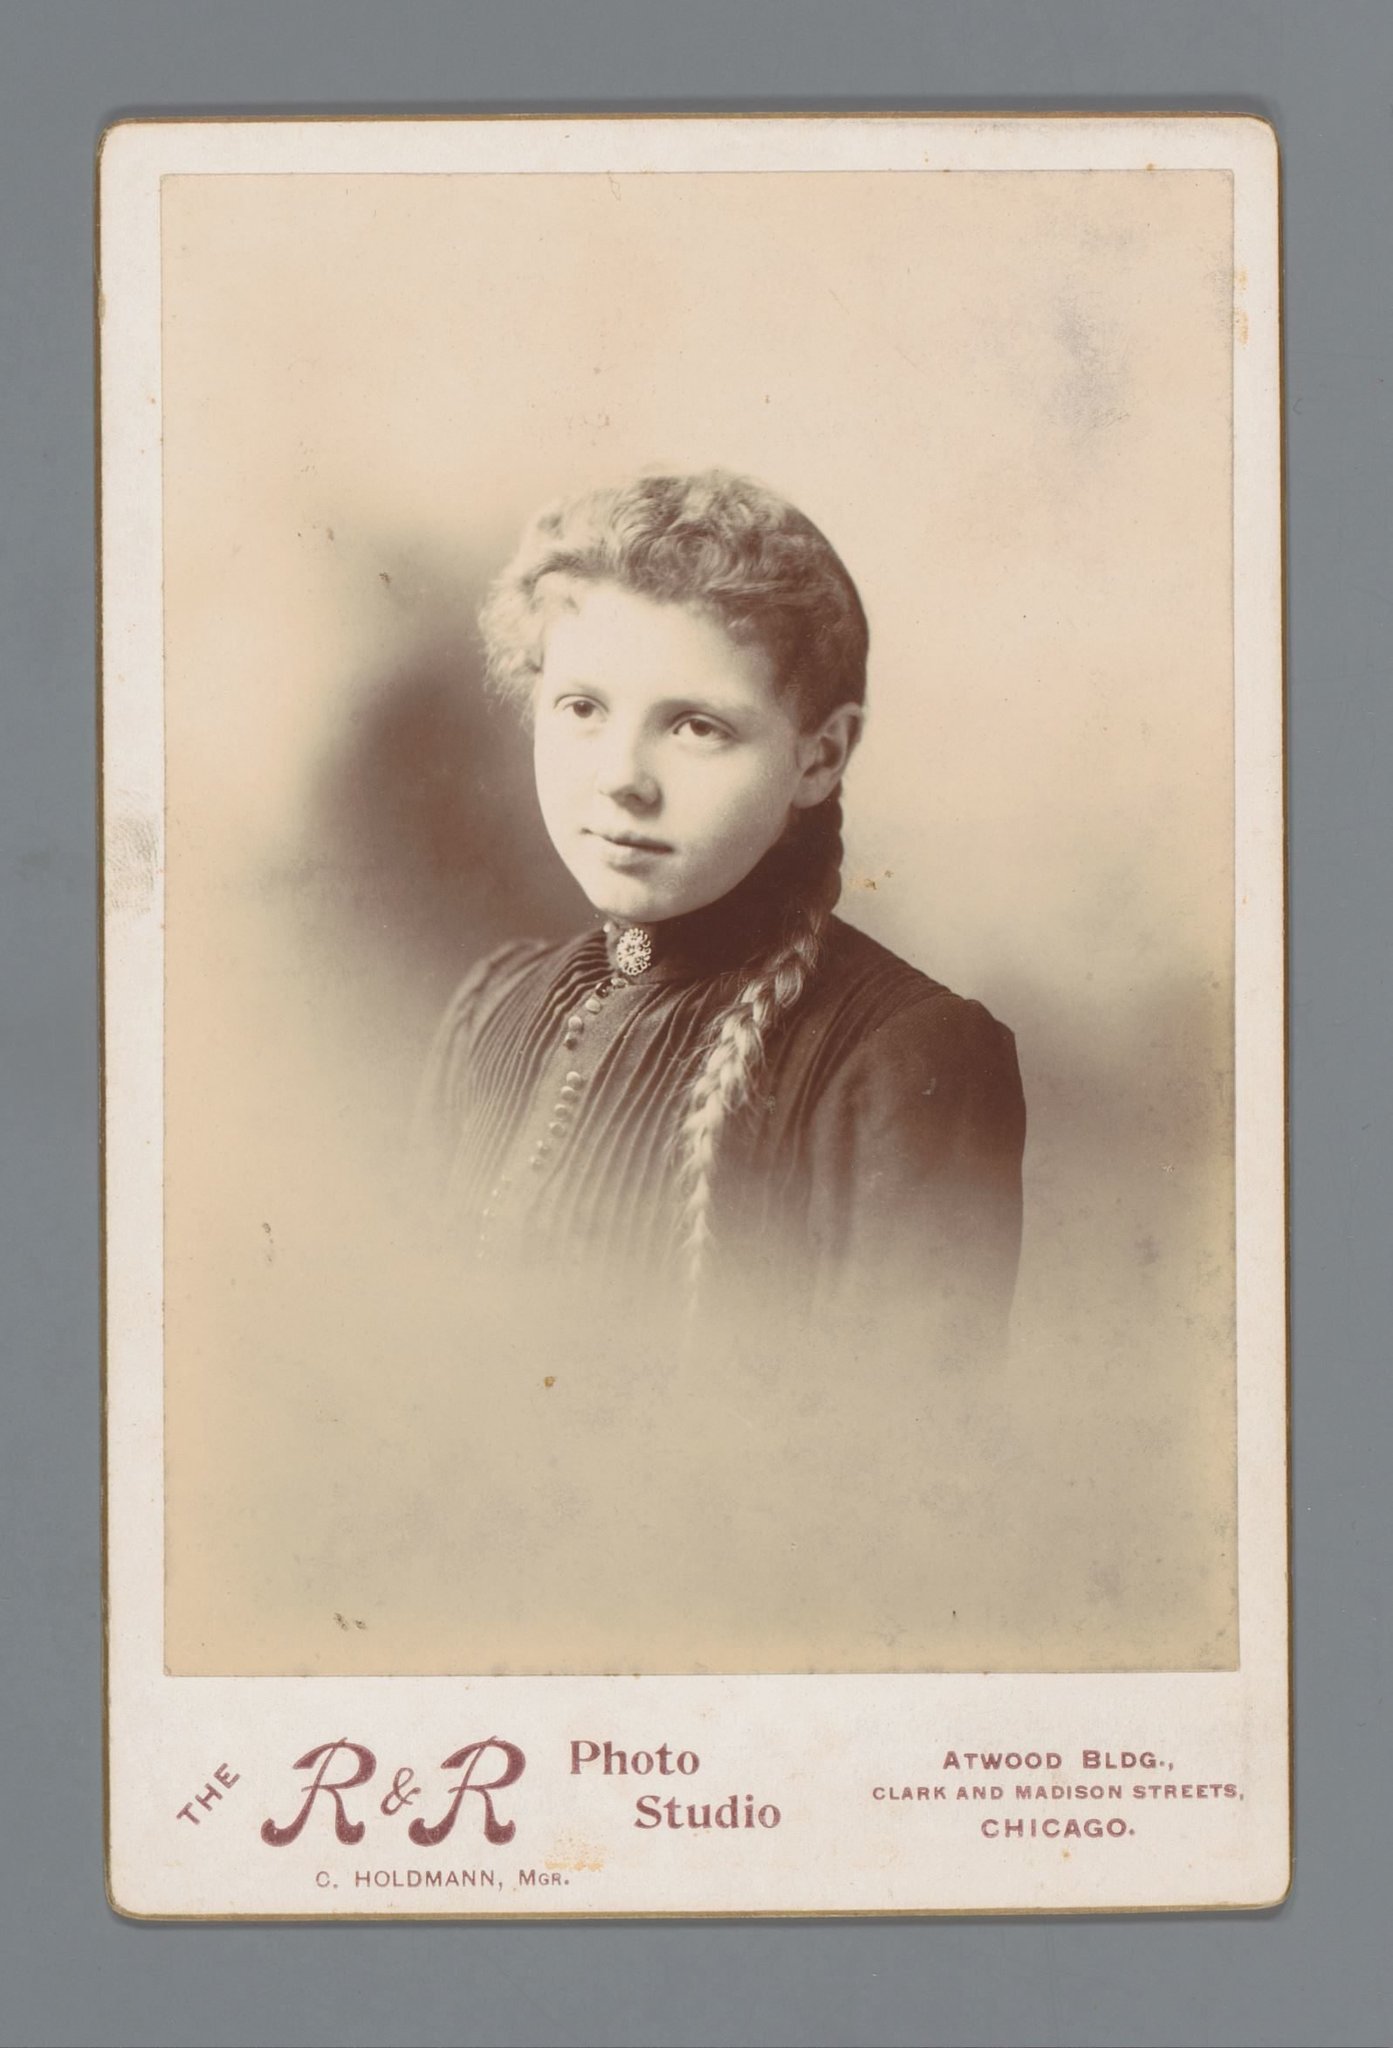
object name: cabinet photograph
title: Portret van een onbekend meisje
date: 1885-1900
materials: cardboard, photographic support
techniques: gelatin silver print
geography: chicago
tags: girl (child between toddler and youth)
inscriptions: name: ‘The R&R Photo Studio Atwood Dldg., Clark and Madison Streets, Chicago.’